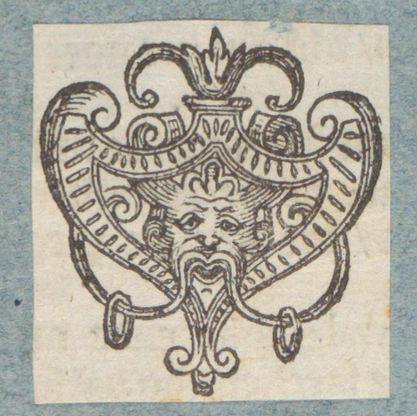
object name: album leaf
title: Ornament met masker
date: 1597-1667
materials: paper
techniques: letterpress printing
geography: amsterdam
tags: mask, ornamental decoration ~ printed matter, book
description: Decoratief ornament met masker. De prent maakt deel uit van een album.